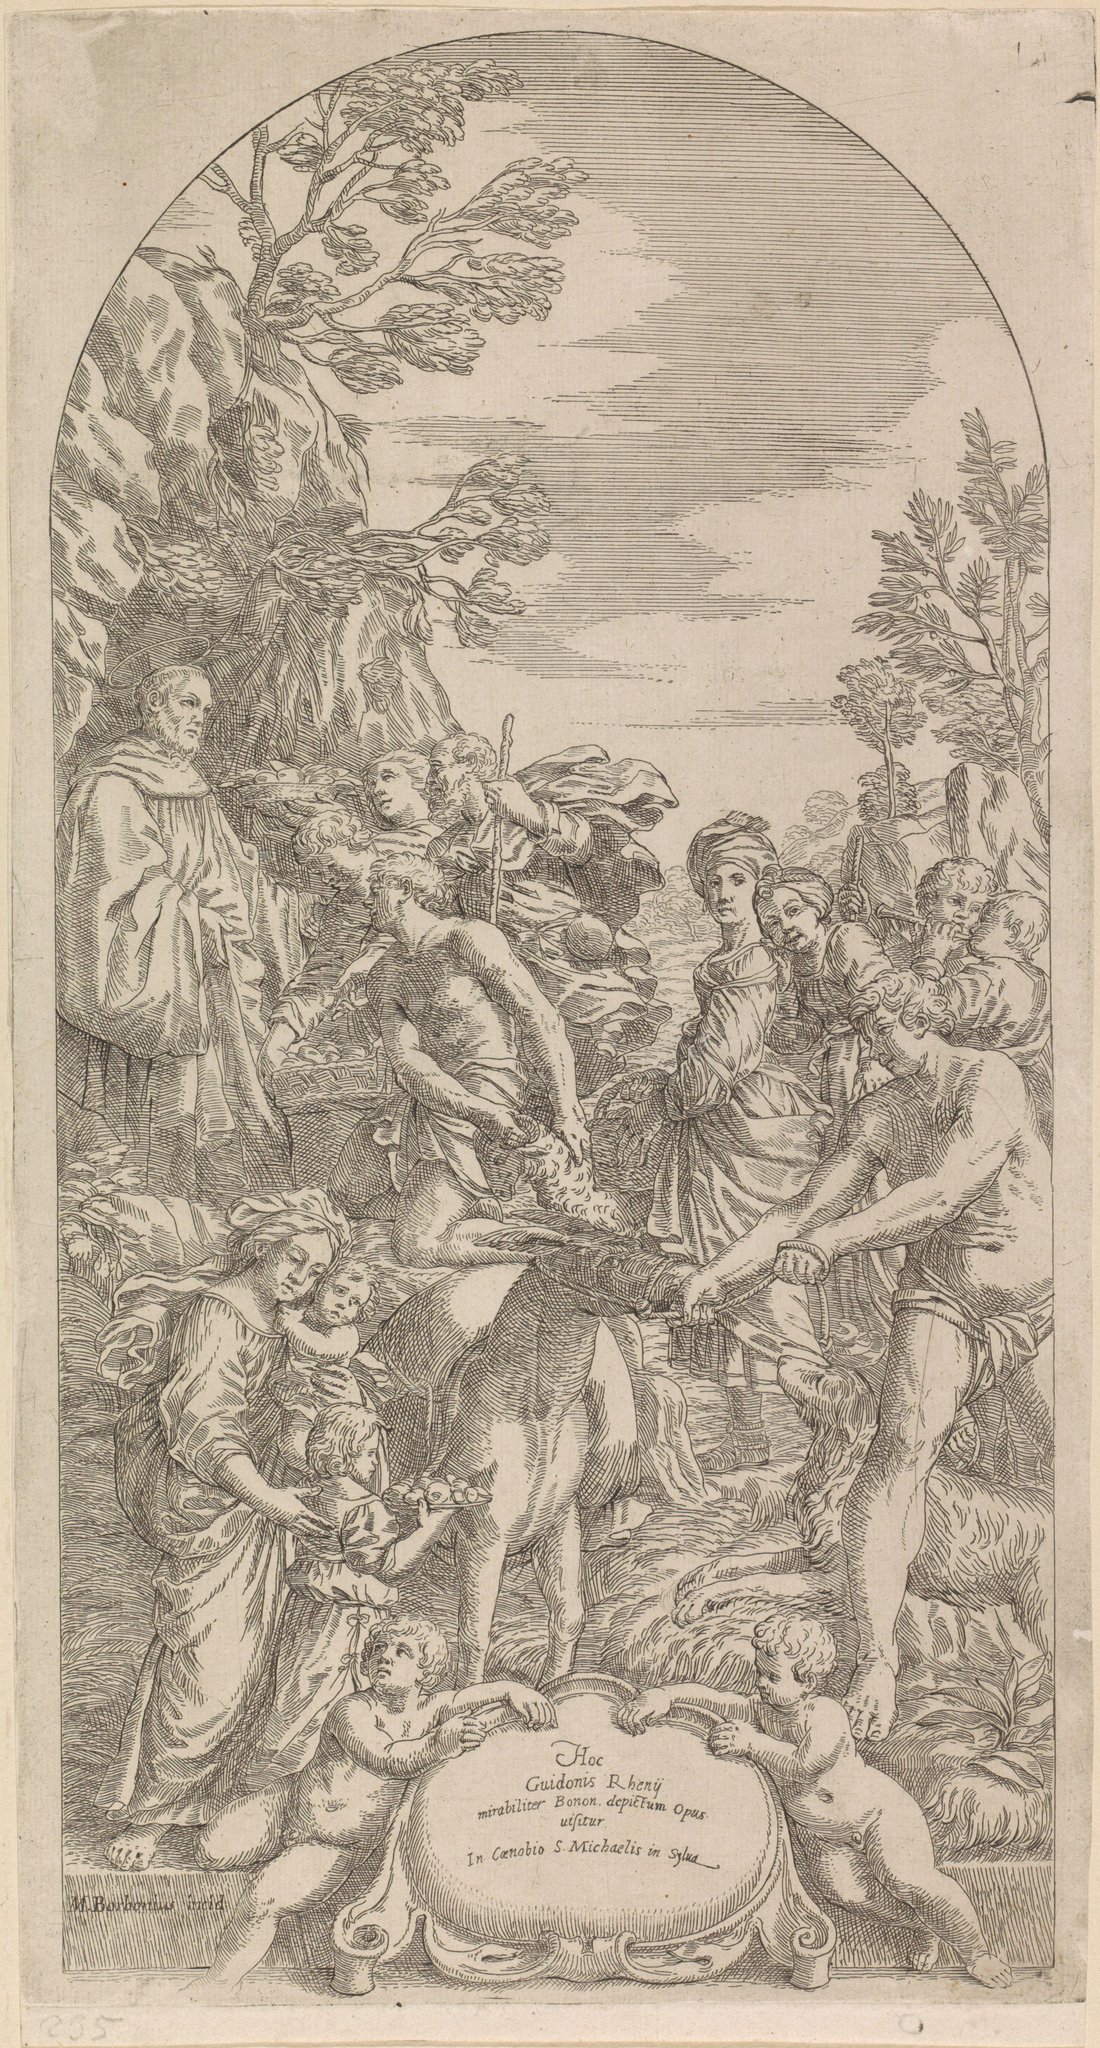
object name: print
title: Heilige Benedictus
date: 1620-1667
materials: paper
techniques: etching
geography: italy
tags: benedict of nurcia, abbot of monte cassino and founder of the benedictine order; possible attributes: aspergillum, book, cup (sometimes broken), raven with loaf, sieve (or tray)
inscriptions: collector's mark: Lugt 240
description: De Heilige Benedictus staat voor een grot. Voor hem een groep van zijn volgelingen die hem eten komen brengen. Midden onder een cartouche aan weerszijden geflankeerd door een putto.